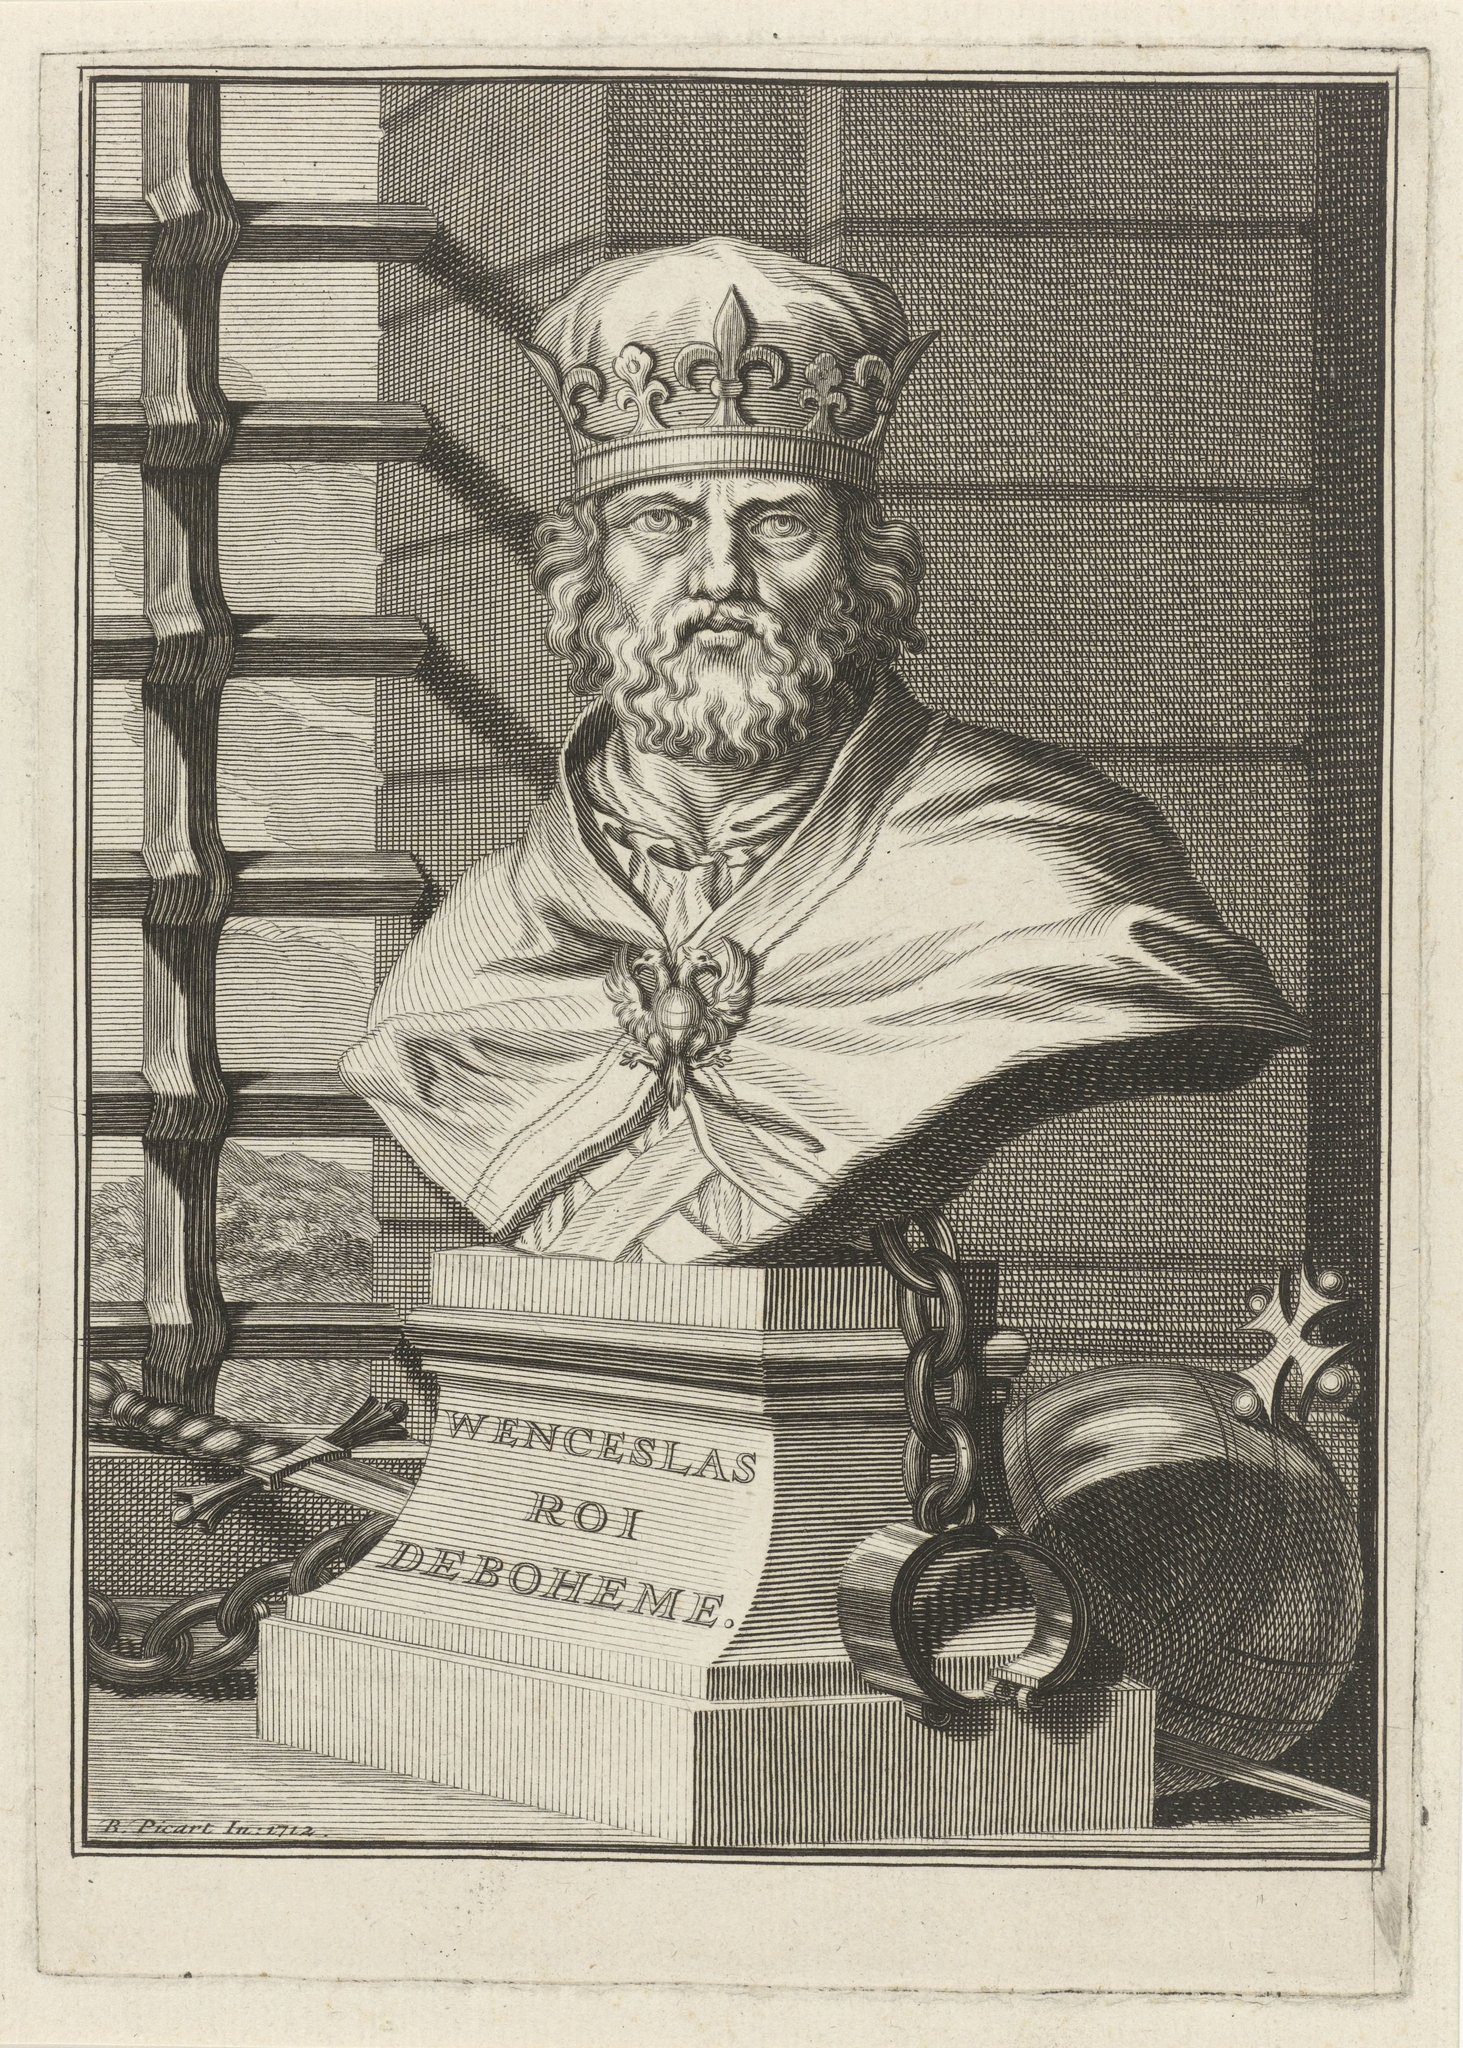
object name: print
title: Buste van Wenceslaus van Bohemen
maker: bernard picart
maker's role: draughtsman, print maker, publisher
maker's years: 1673-1733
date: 1712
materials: paper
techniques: engraving, etching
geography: amsterdam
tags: prague, orb (symbol of sovereignty; sphere with cross on top), knighthood order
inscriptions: collector's mark: Lugt 2228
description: Buste van Wenceslaus, koning van Bohemen. Op zijn mantel het teken van de Orde van de Witte Adelaar. Achter de buste een rijksappel.